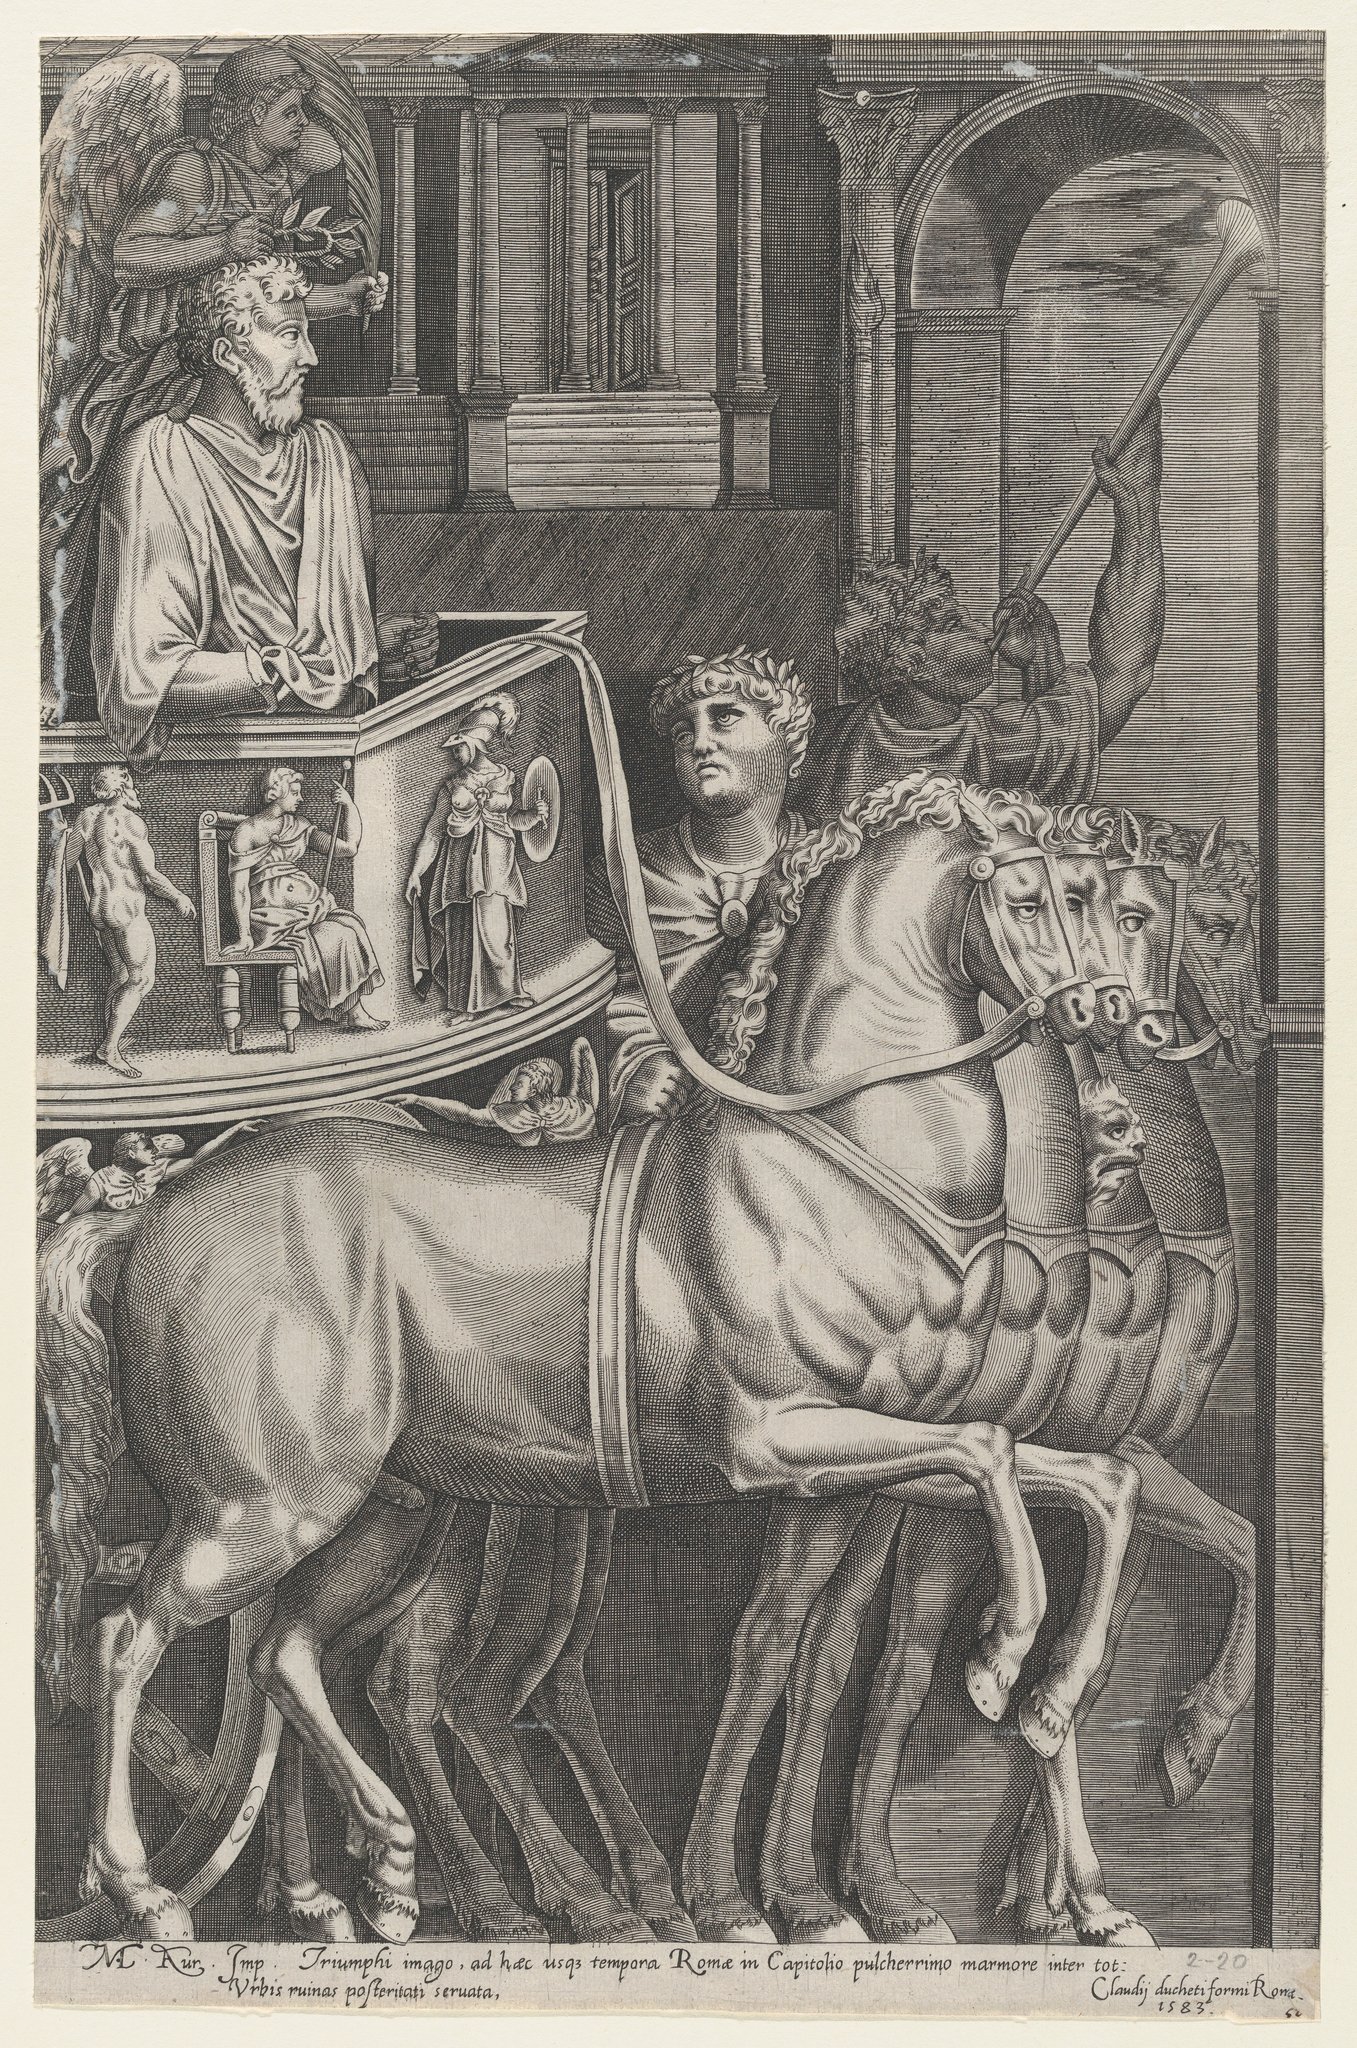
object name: print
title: Triumph of Marcus Aurelius, from "Speculum Romanae Magnificentiae"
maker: Anonymous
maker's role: artist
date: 1583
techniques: engraving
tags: musical instruments,men,horses,chariots